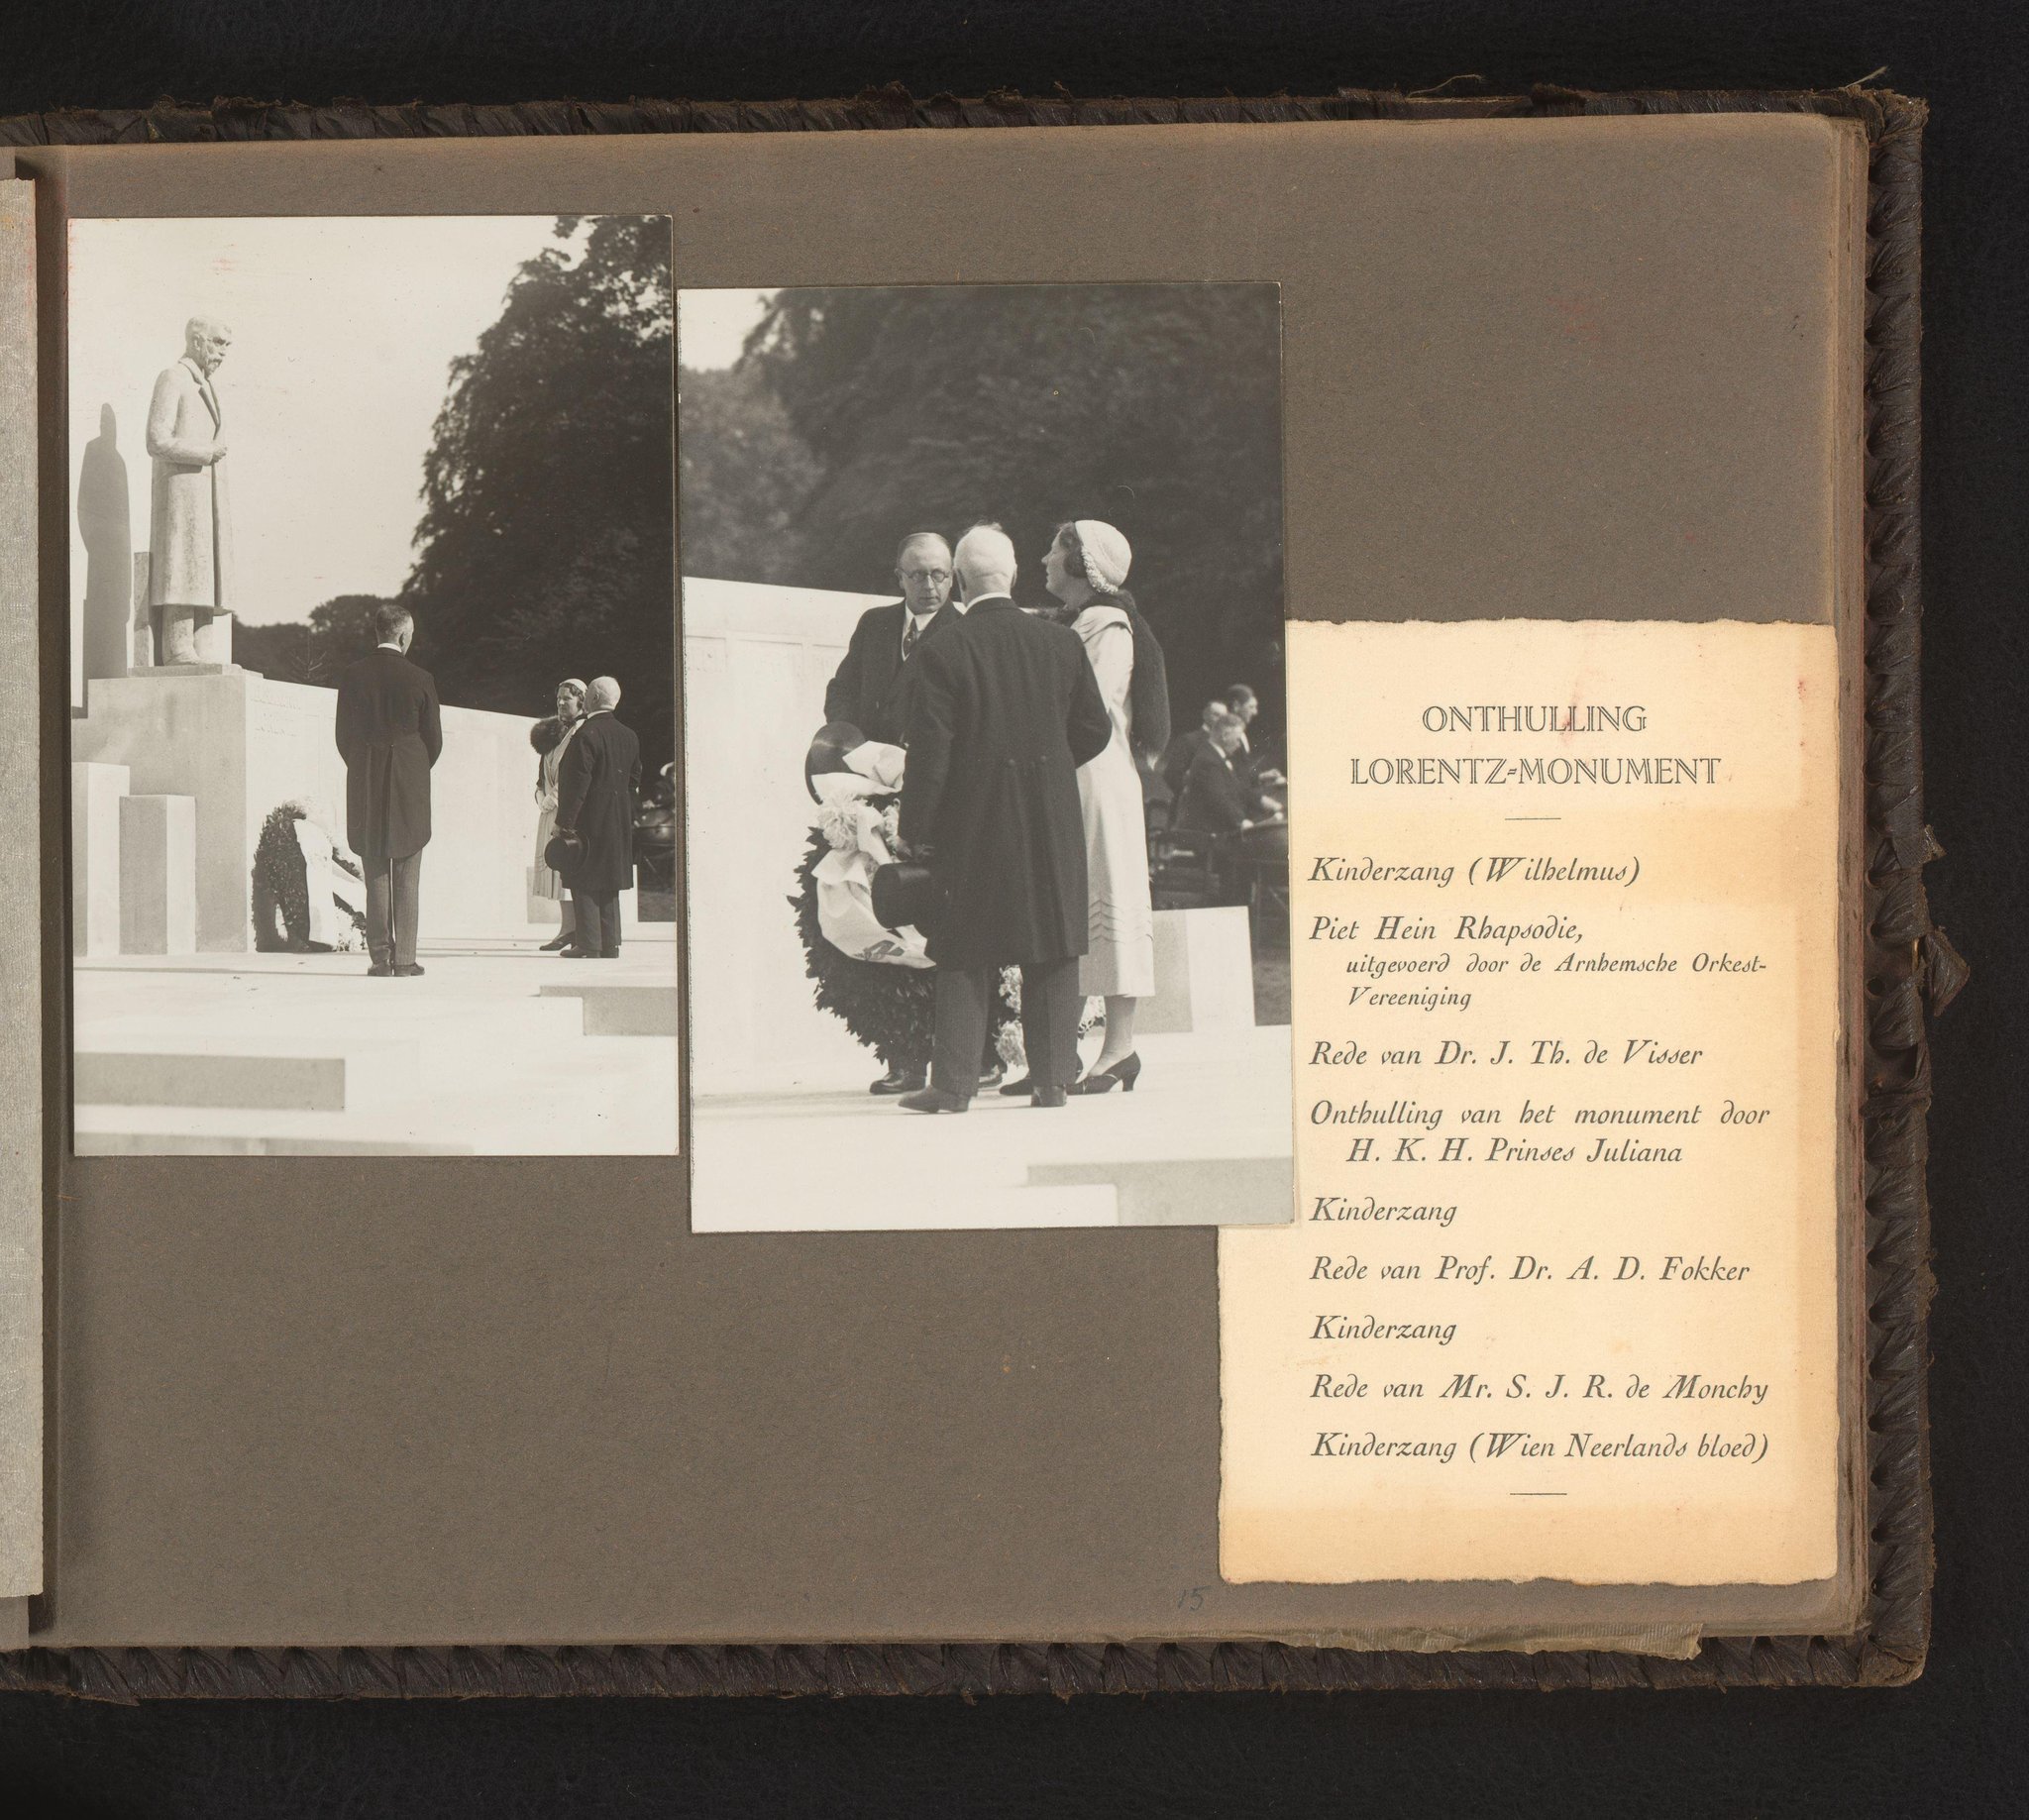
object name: programma, programmaboekje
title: Twee foto's van prinses Juliana bij de onthulling van het Lorentzmonument in Arnhem en het programma van de onthullingsplechtigheid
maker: Anonymous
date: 1931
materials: paper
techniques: gelatin silver print, printing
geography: arnhem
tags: the hague, juliana of the netherlands, adolescent, young woman, maiden, monument, statue, arnhem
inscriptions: inscription: ‘Onthulling/ Lorentz-Monument/ Kinderzang (Wilhelmus) (...) Kinderzang (Wien Neerlands bloed)’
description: Deze foto's maken deel uit van een album.